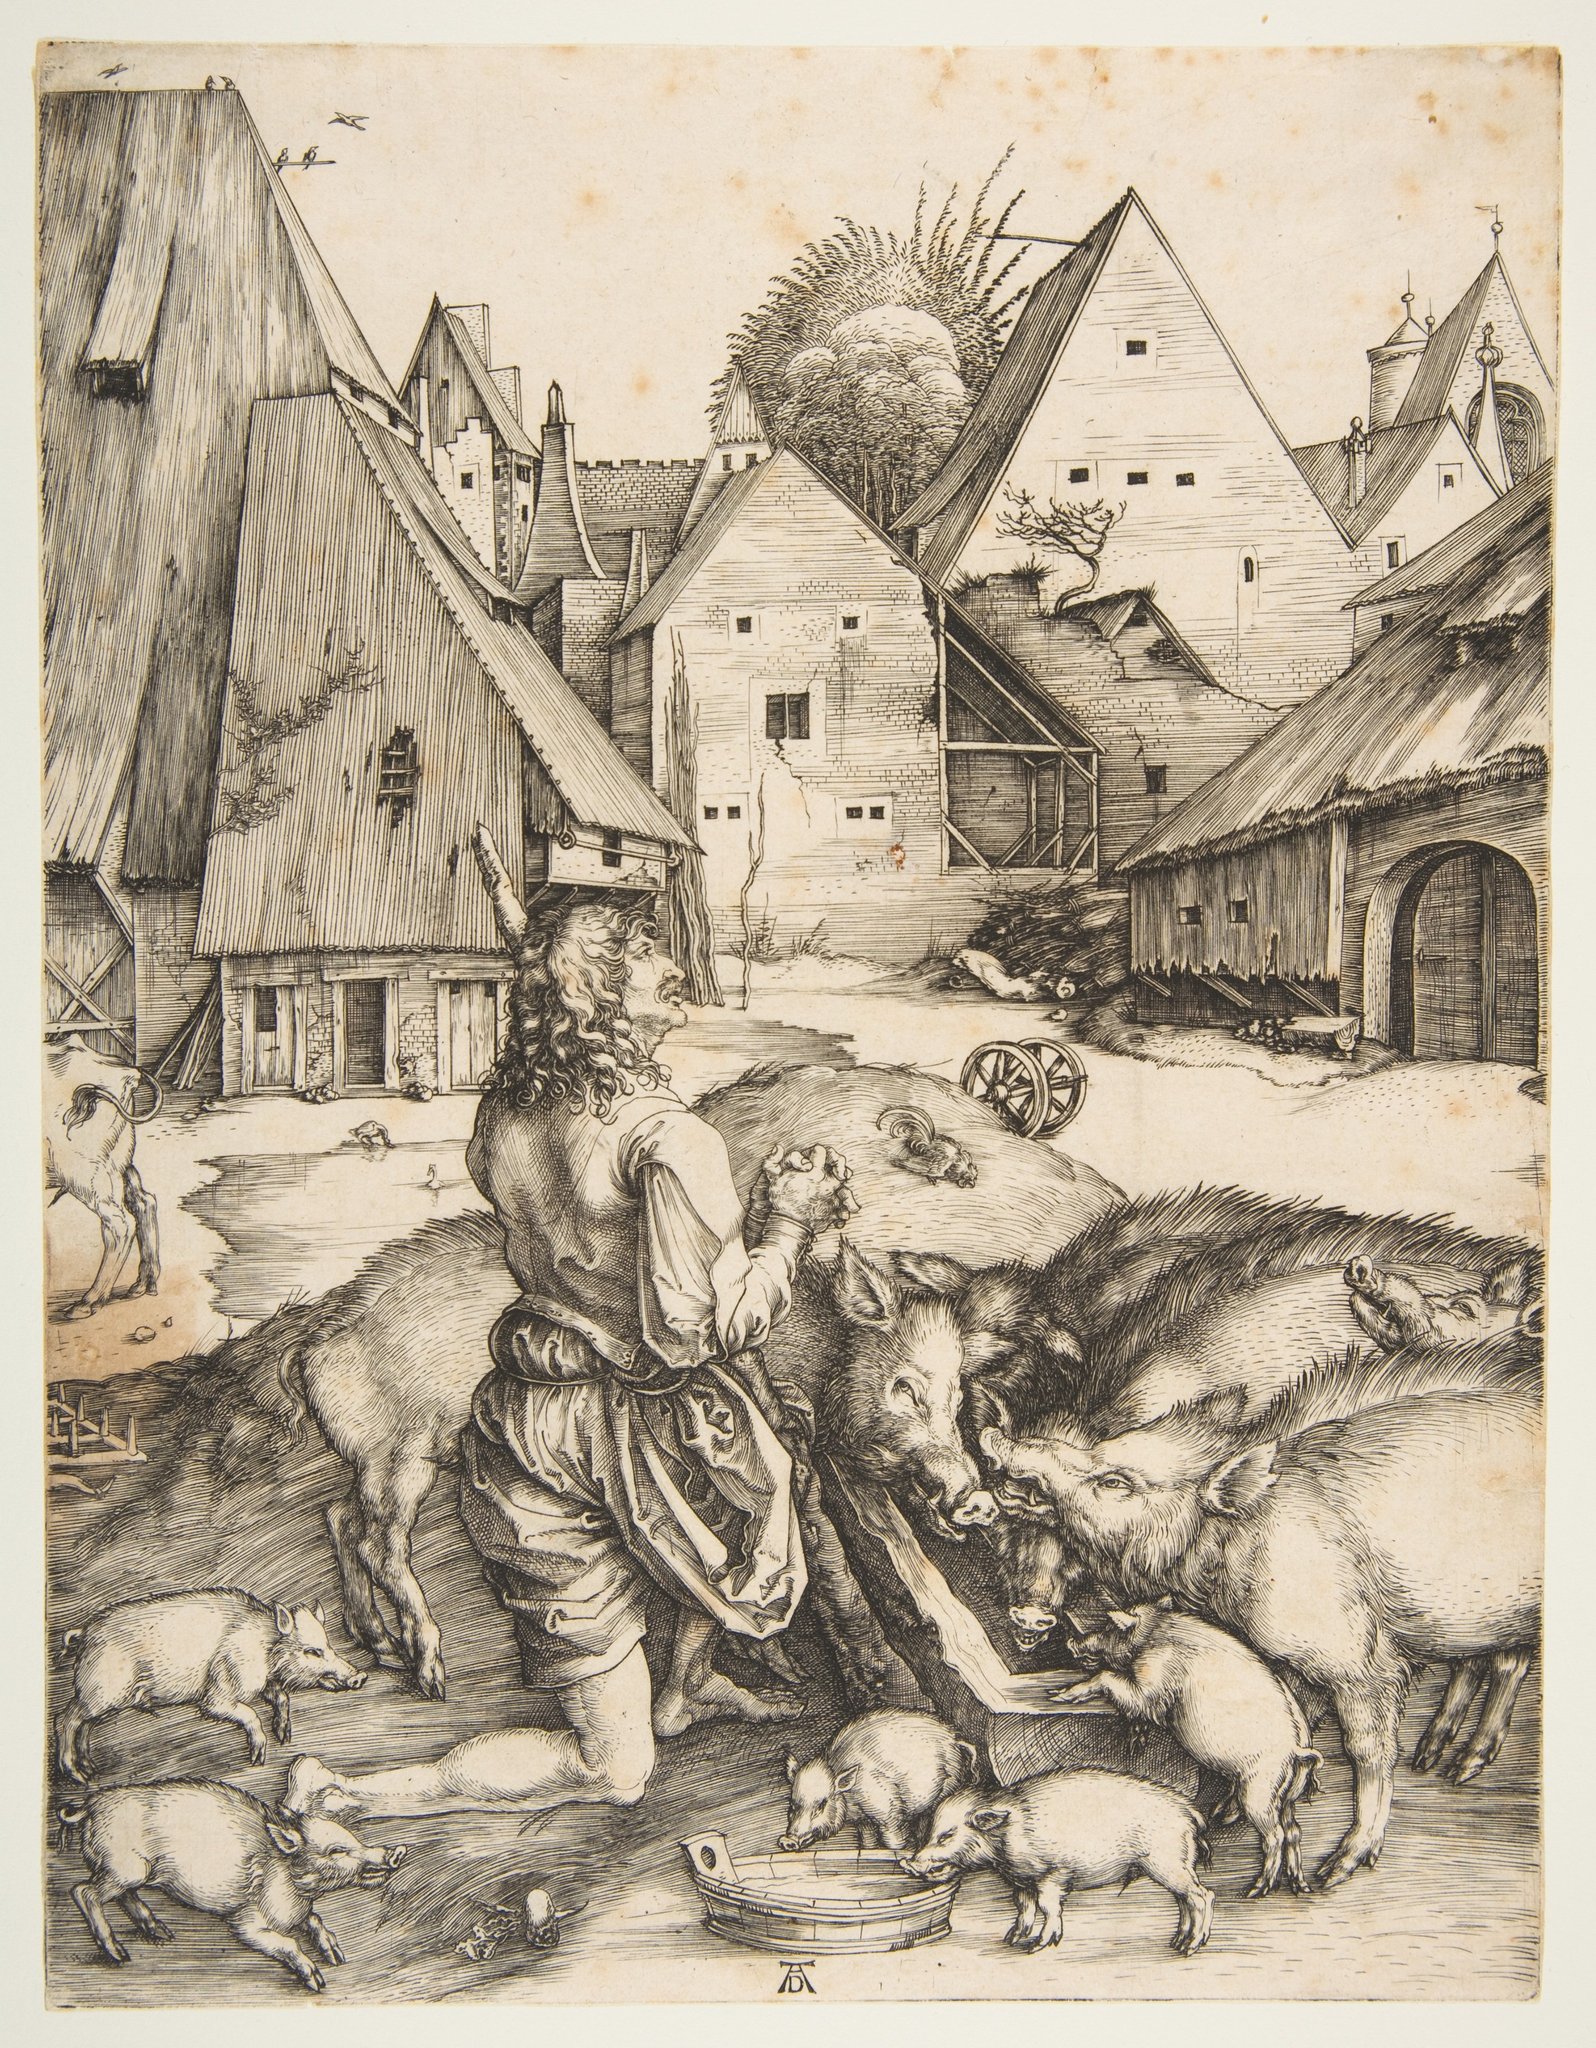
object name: print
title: The Prodigal Son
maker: albrecht dürer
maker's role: artist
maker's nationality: german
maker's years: 1471-1528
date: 1496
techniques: engraving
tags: buildings,men,pigs